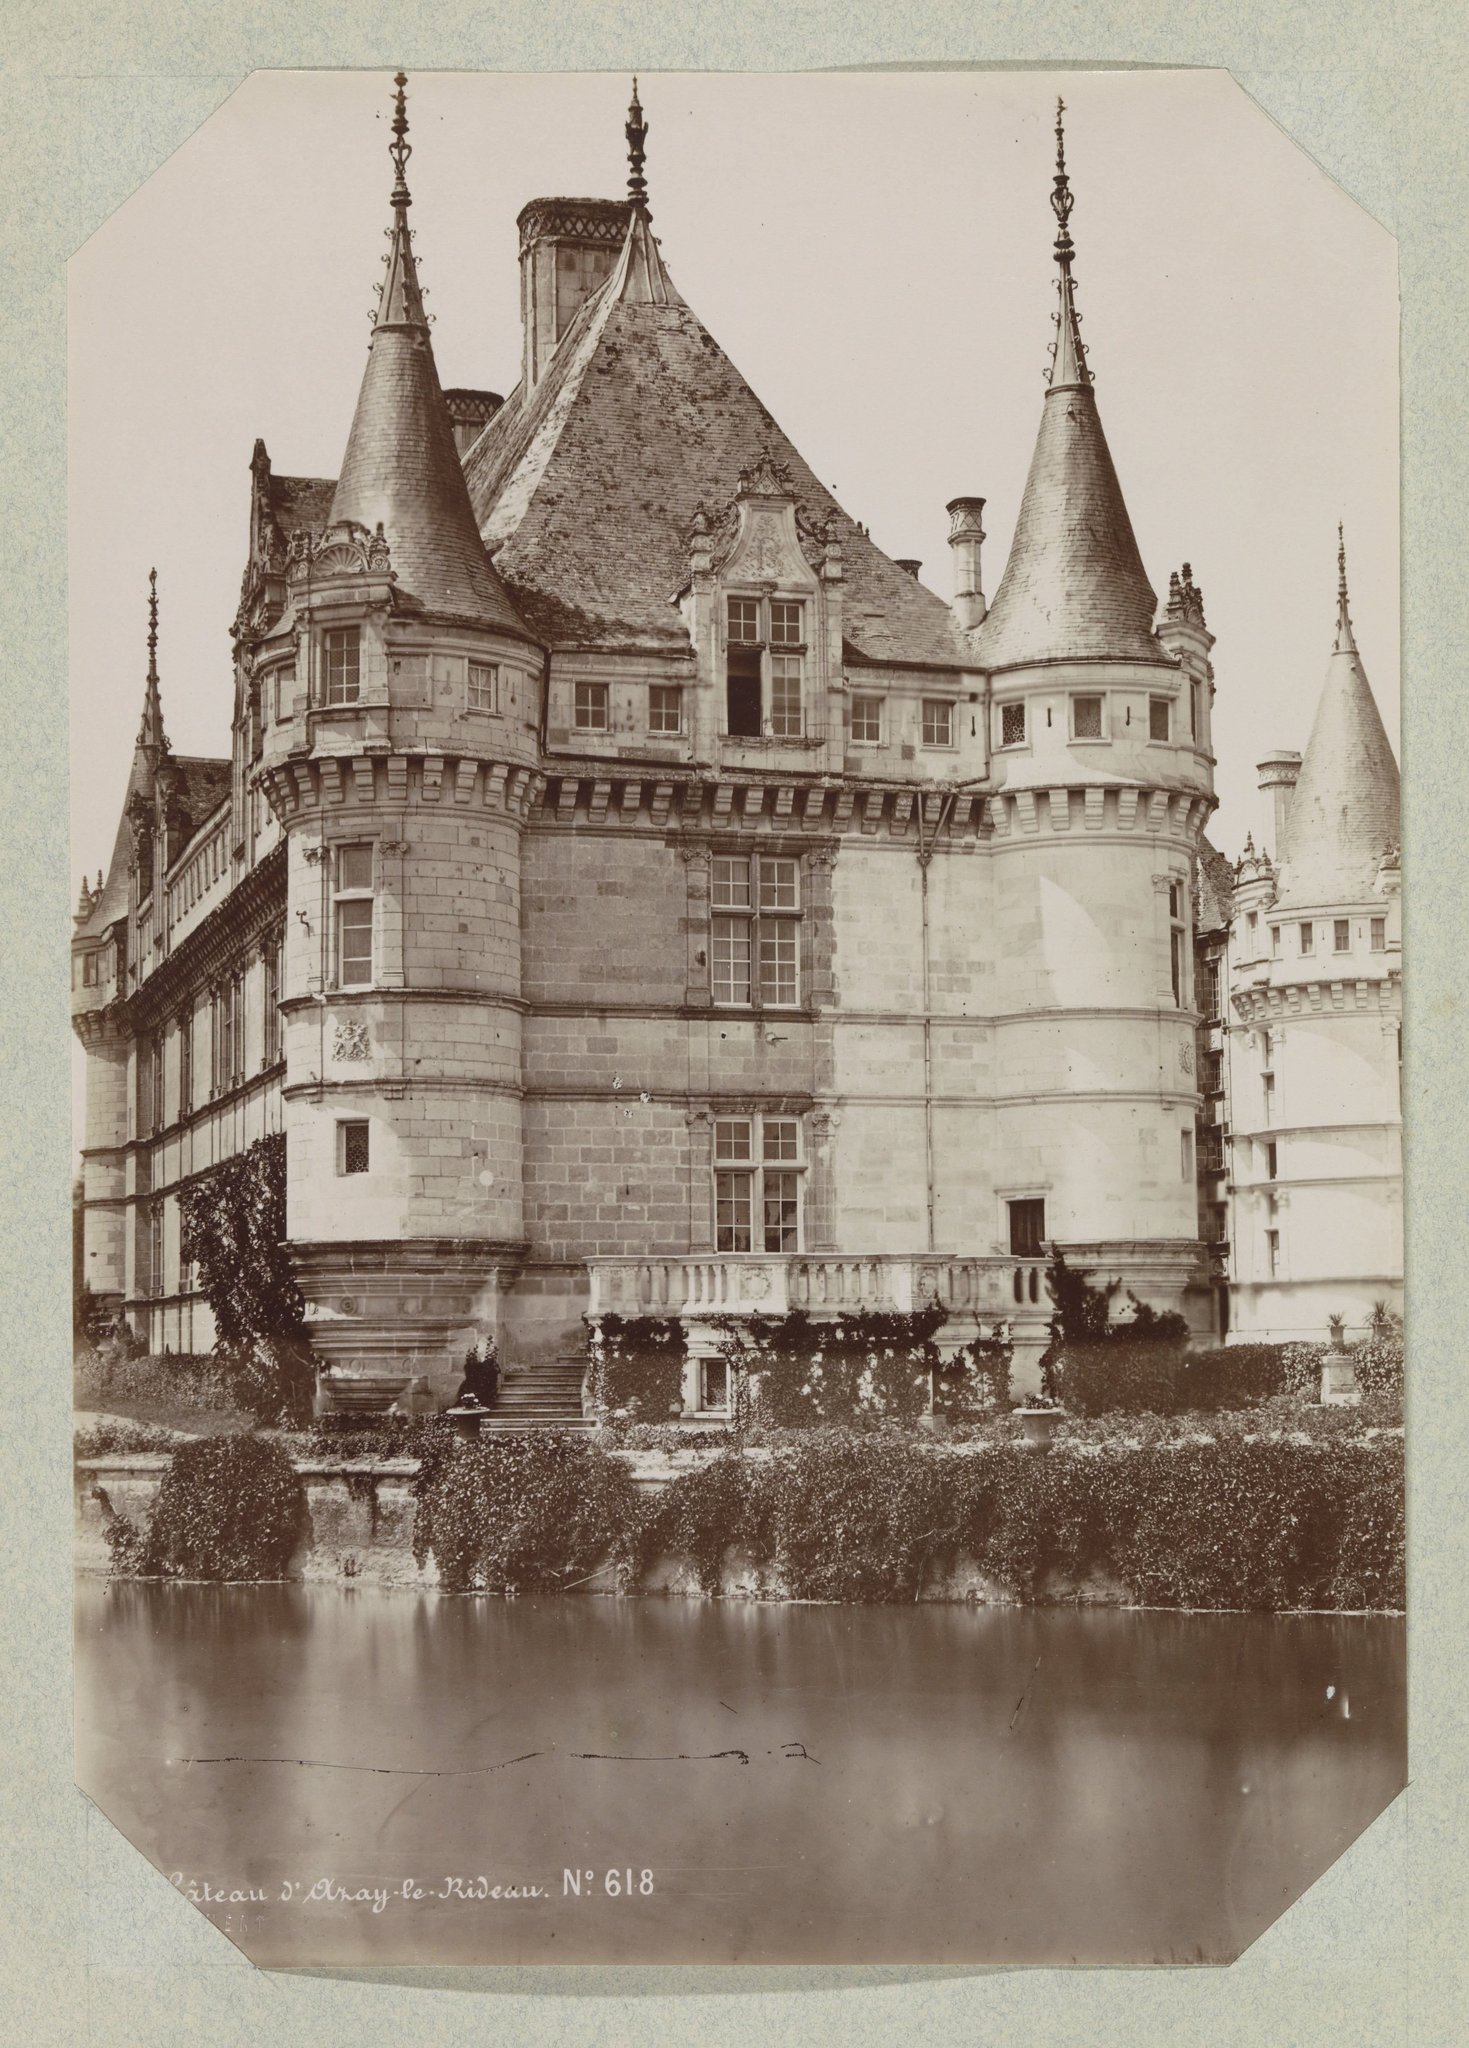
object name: photograph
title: Château d'Azay-le-Rideau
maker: séraphin-médéric mieusement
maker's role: fotograaf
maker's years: 1840-1905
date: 1880-1900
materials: photographic support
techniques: albumen print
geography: azay-le-rideau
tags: castle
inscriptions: name: ‘Mieusement photographe’, inscription: ‘Monuments Historiques’, number: ‘618’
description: Onderdeel van Fotoalbum met opnames van monumenten in Frankrijk.